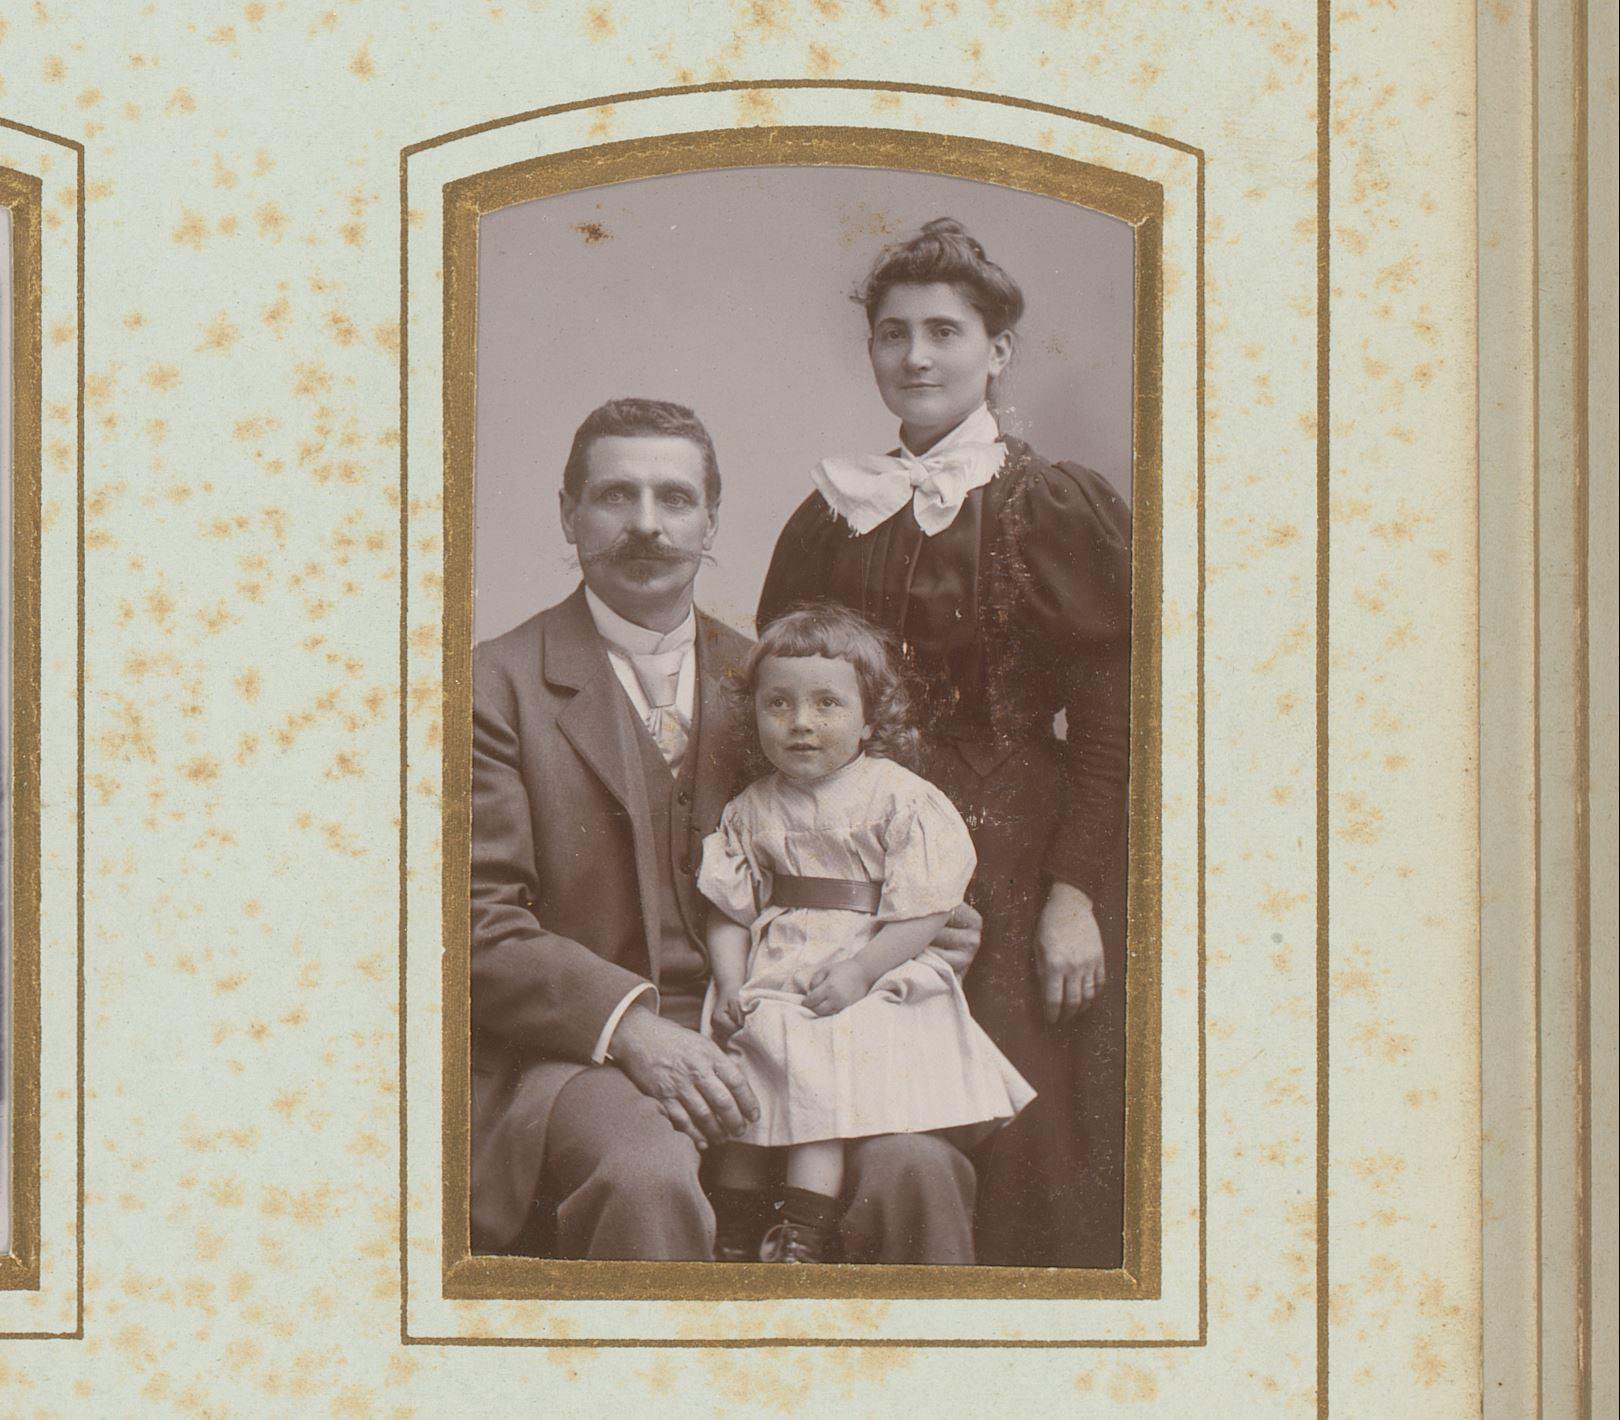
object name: carte de visite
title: Groepsportret van een gezin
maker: Anonymous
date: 1880-1920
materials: cardboard, photographic support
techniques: collodion silver print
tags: family group, especially parents with their child(ren)